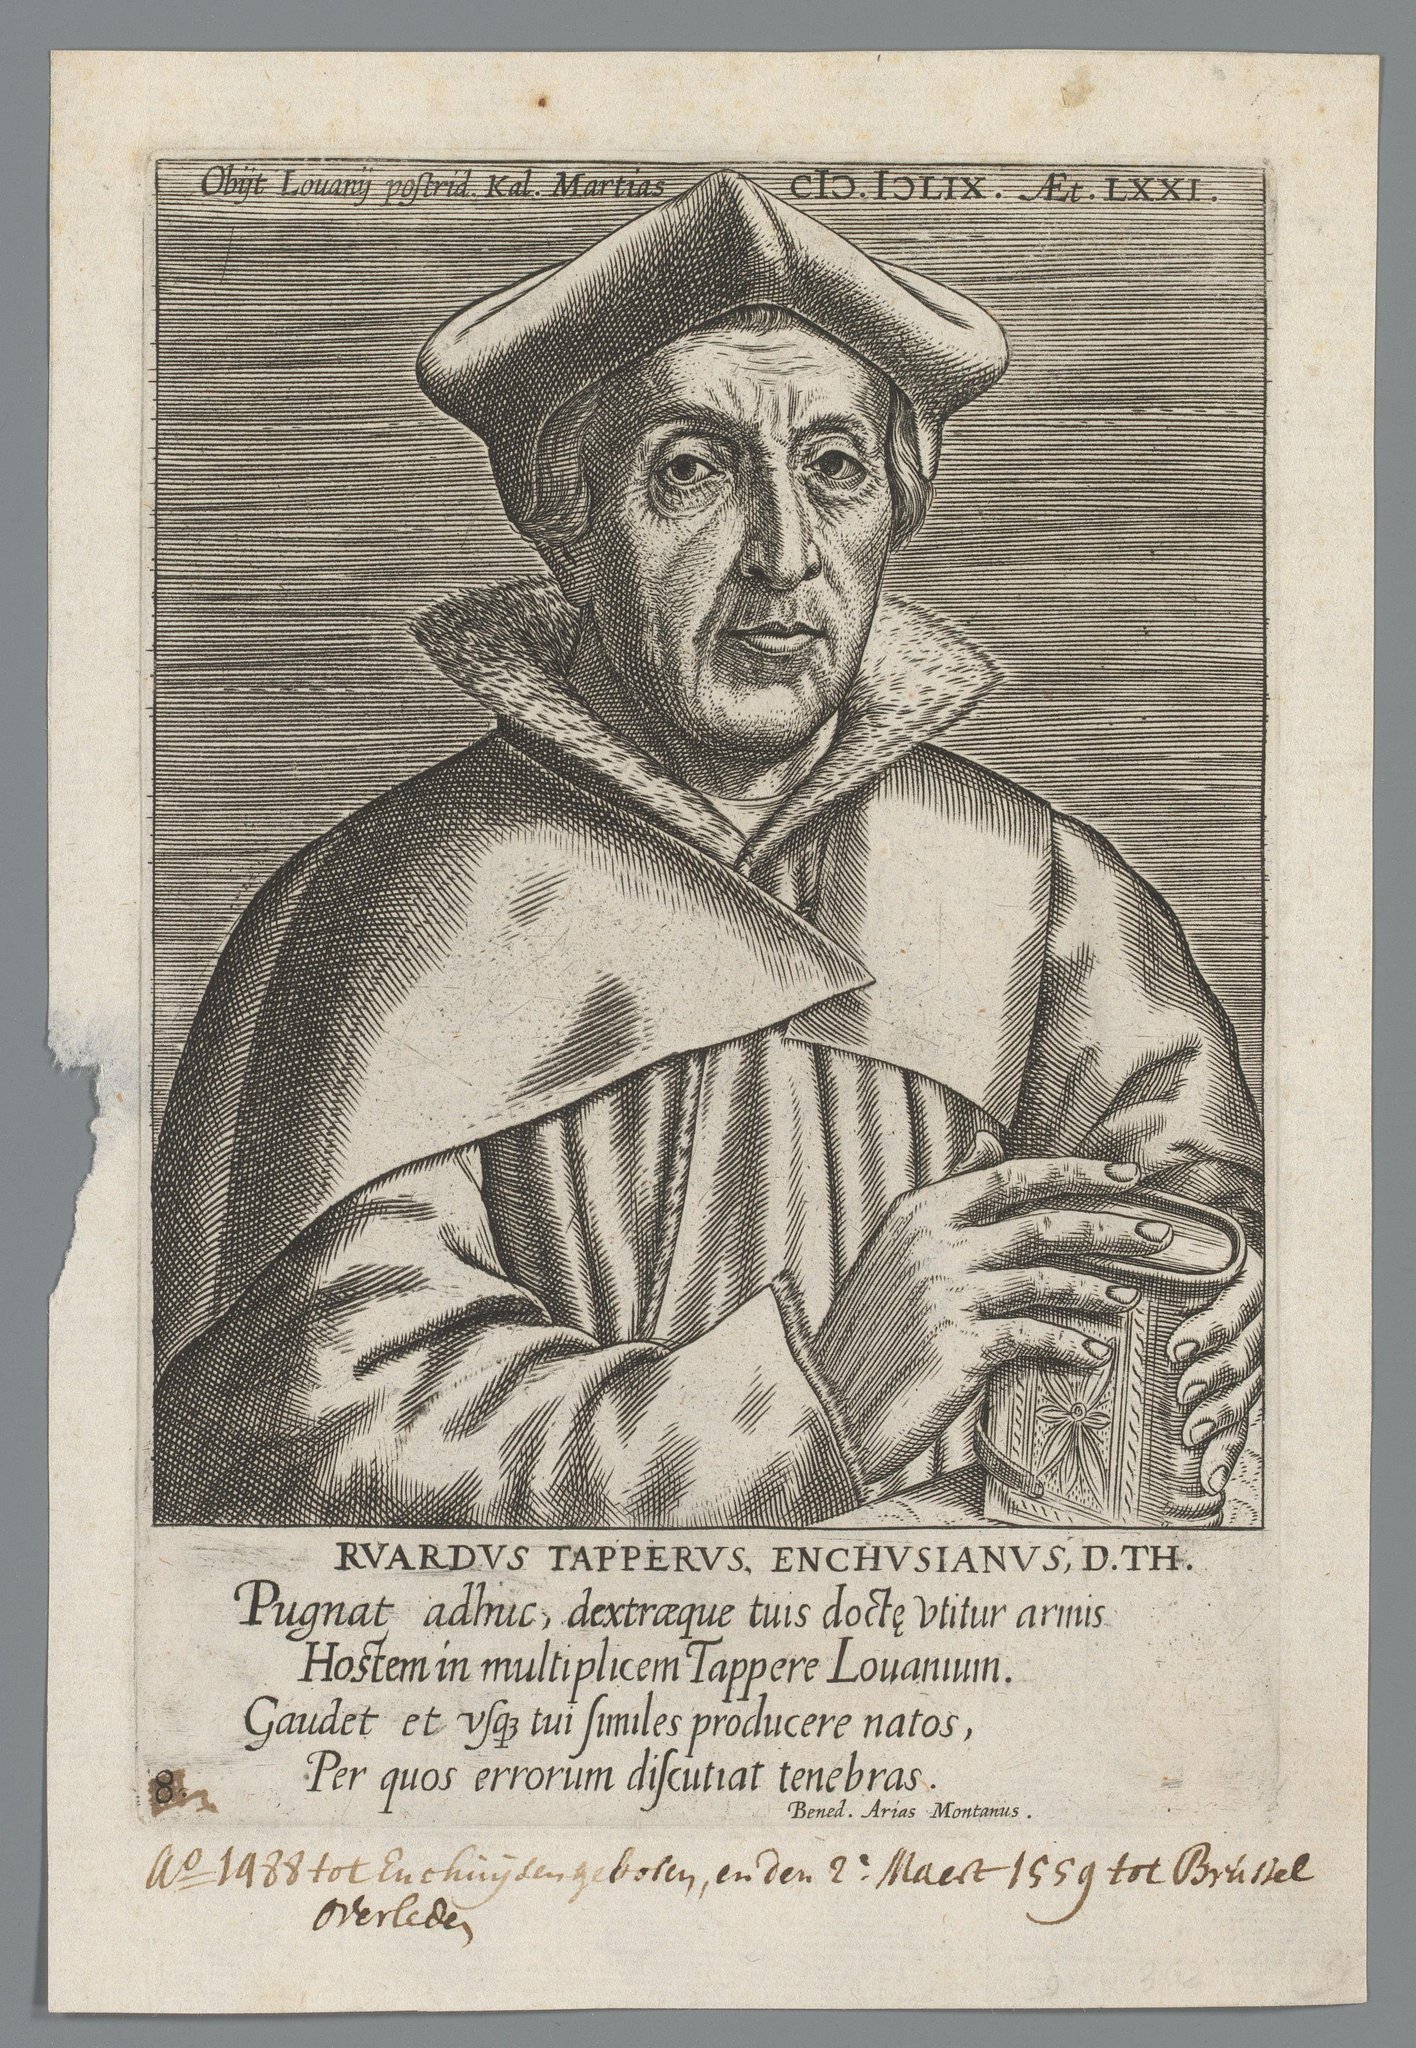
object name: book illustration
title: Illustrium Galliae Belgicae scriptorum icones et elogi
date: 1604-1608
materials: paper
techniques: engraving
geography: antwerp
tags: enkhuizen, theologian, historical persons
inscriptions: inscription: ‘Ao 1488 tot Enchuijsen geboren, en den 2: Maert 1559 tot Brussel overleden’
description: Prent waarschijnlijk uit: Le-Mire, Aubertus. Illustrium Galliae Belgicae Scriptorum icones et elogia. Antwerpen: Theodoor Galle, 1609.